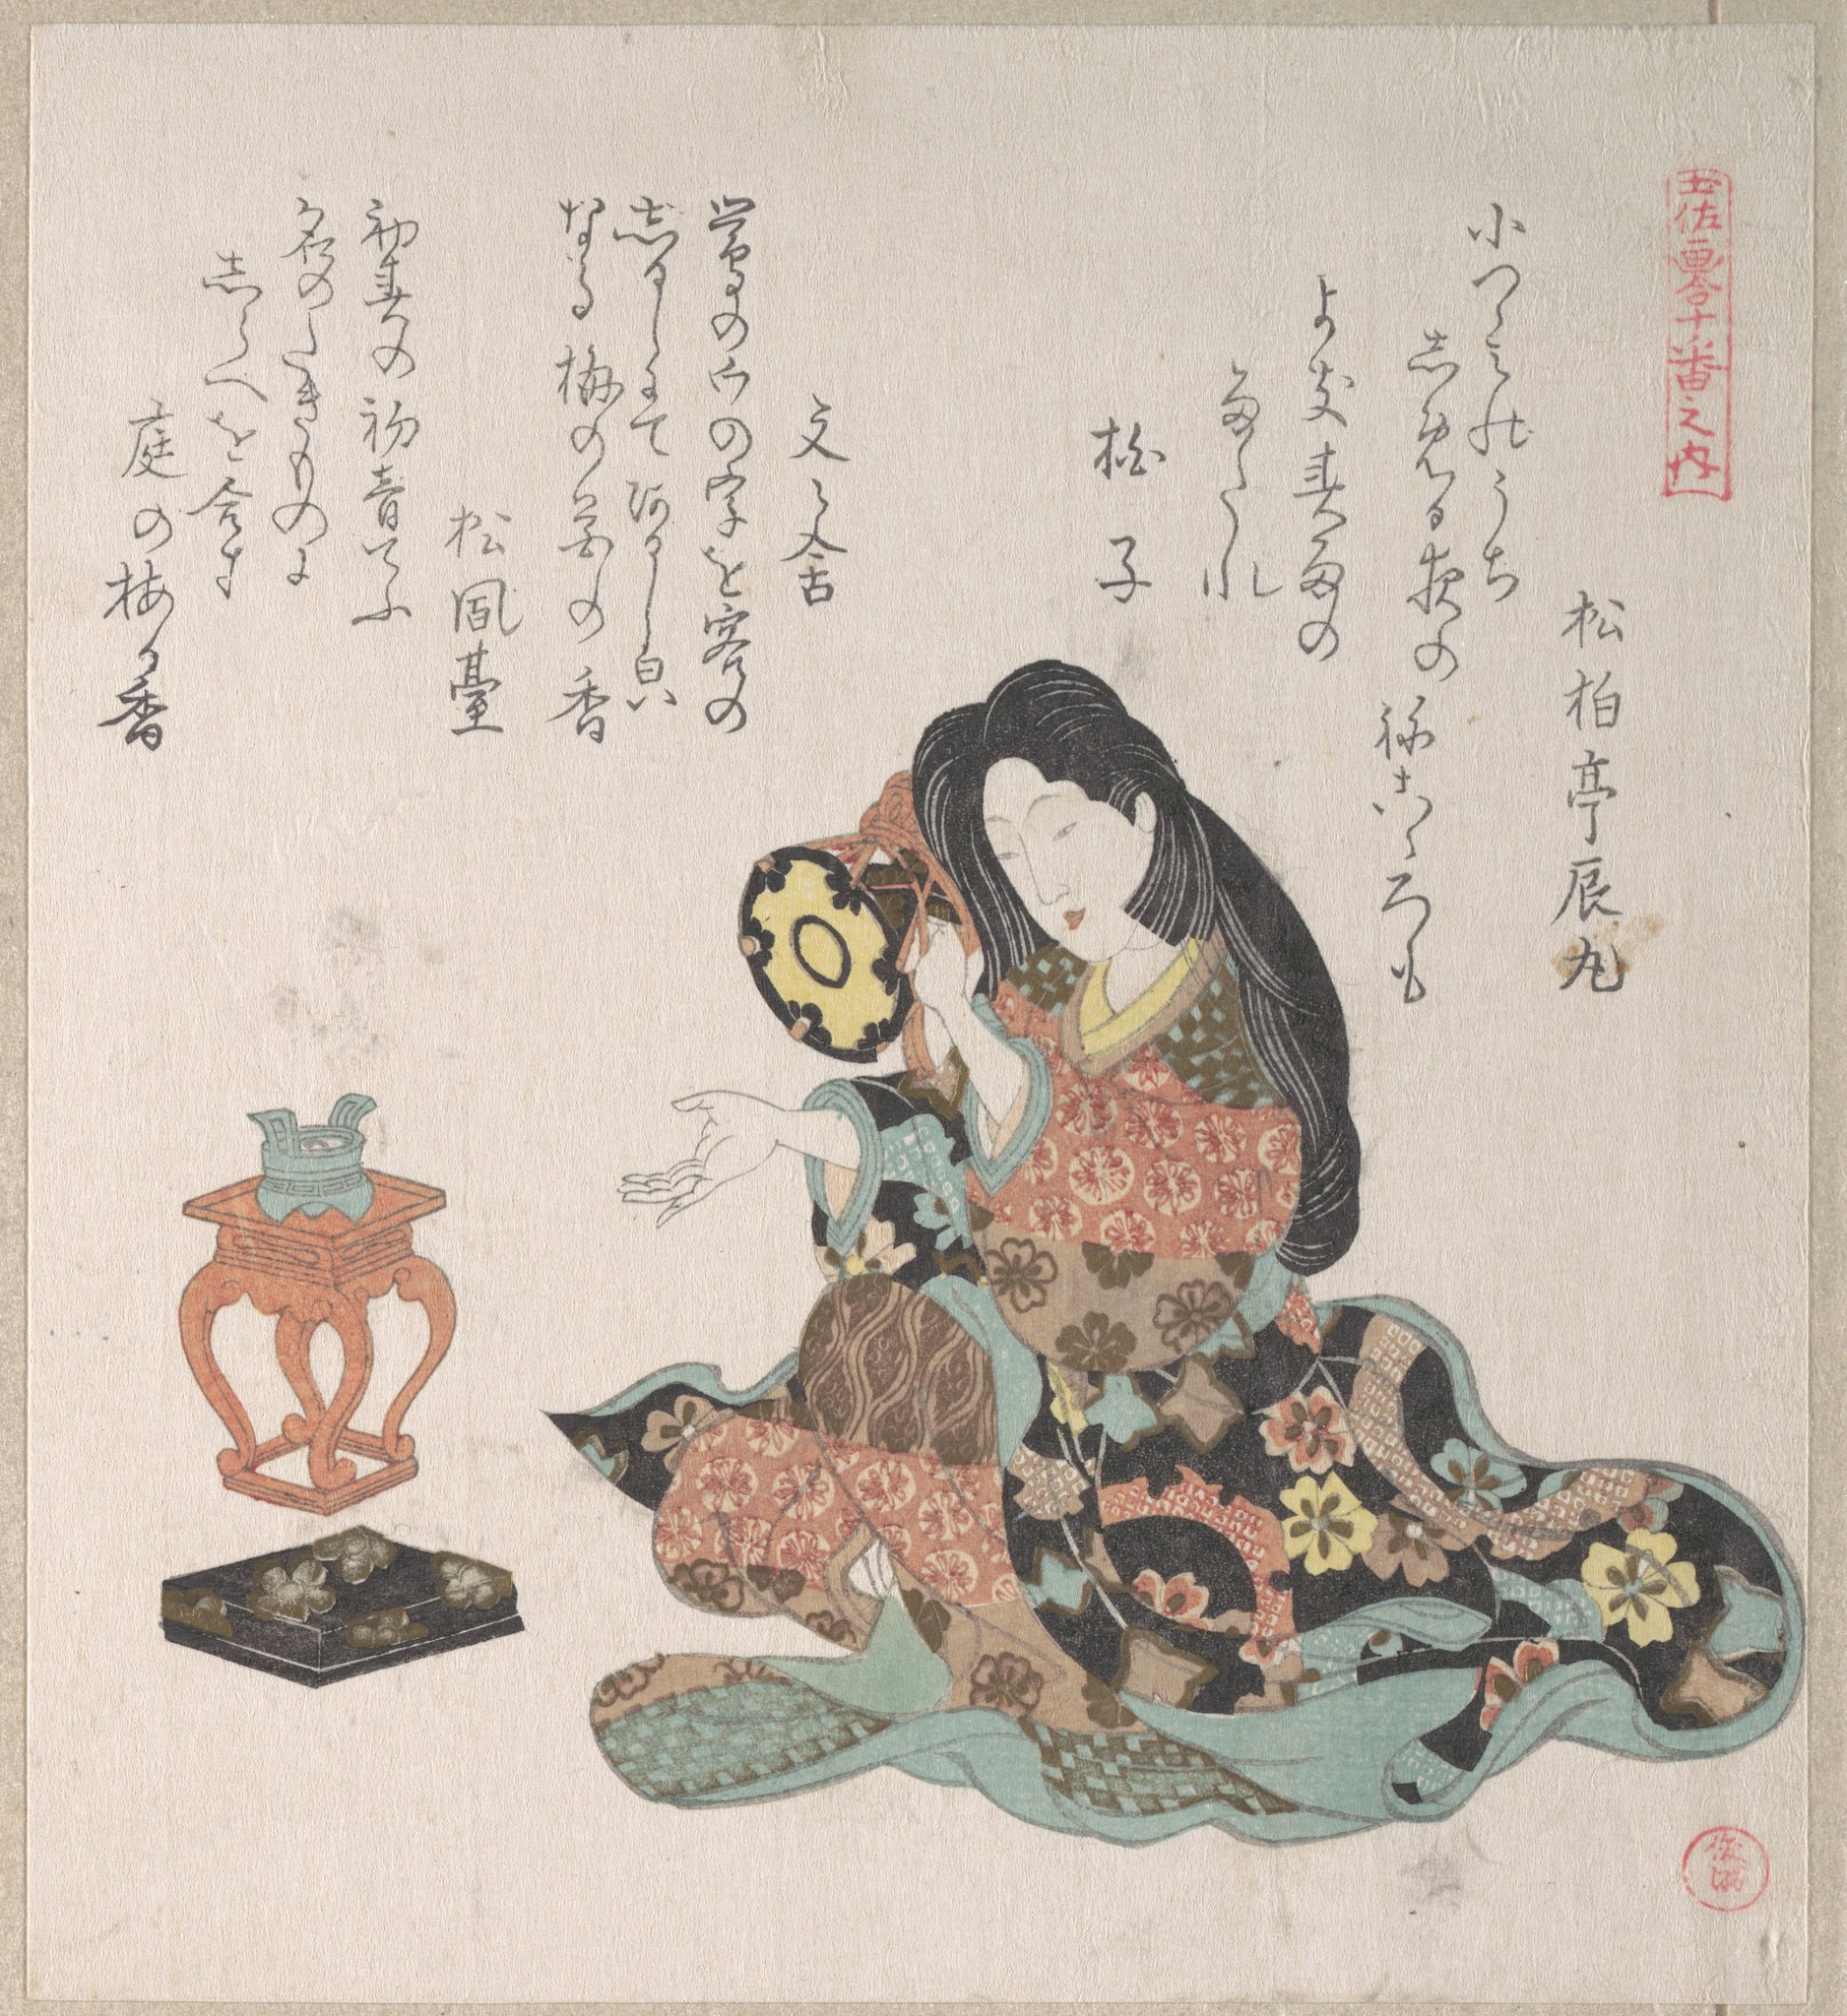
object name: woodblock print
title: Lady Beating a Hand-Drum (Tzusumi) By the Side of The Incense Burner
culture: japanese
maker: kubo shunman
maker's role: artist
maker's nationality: japanese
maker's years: 1757-1820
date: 1815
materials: ink, paper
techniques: surimono, woodblock print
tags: women,drums,incense burners